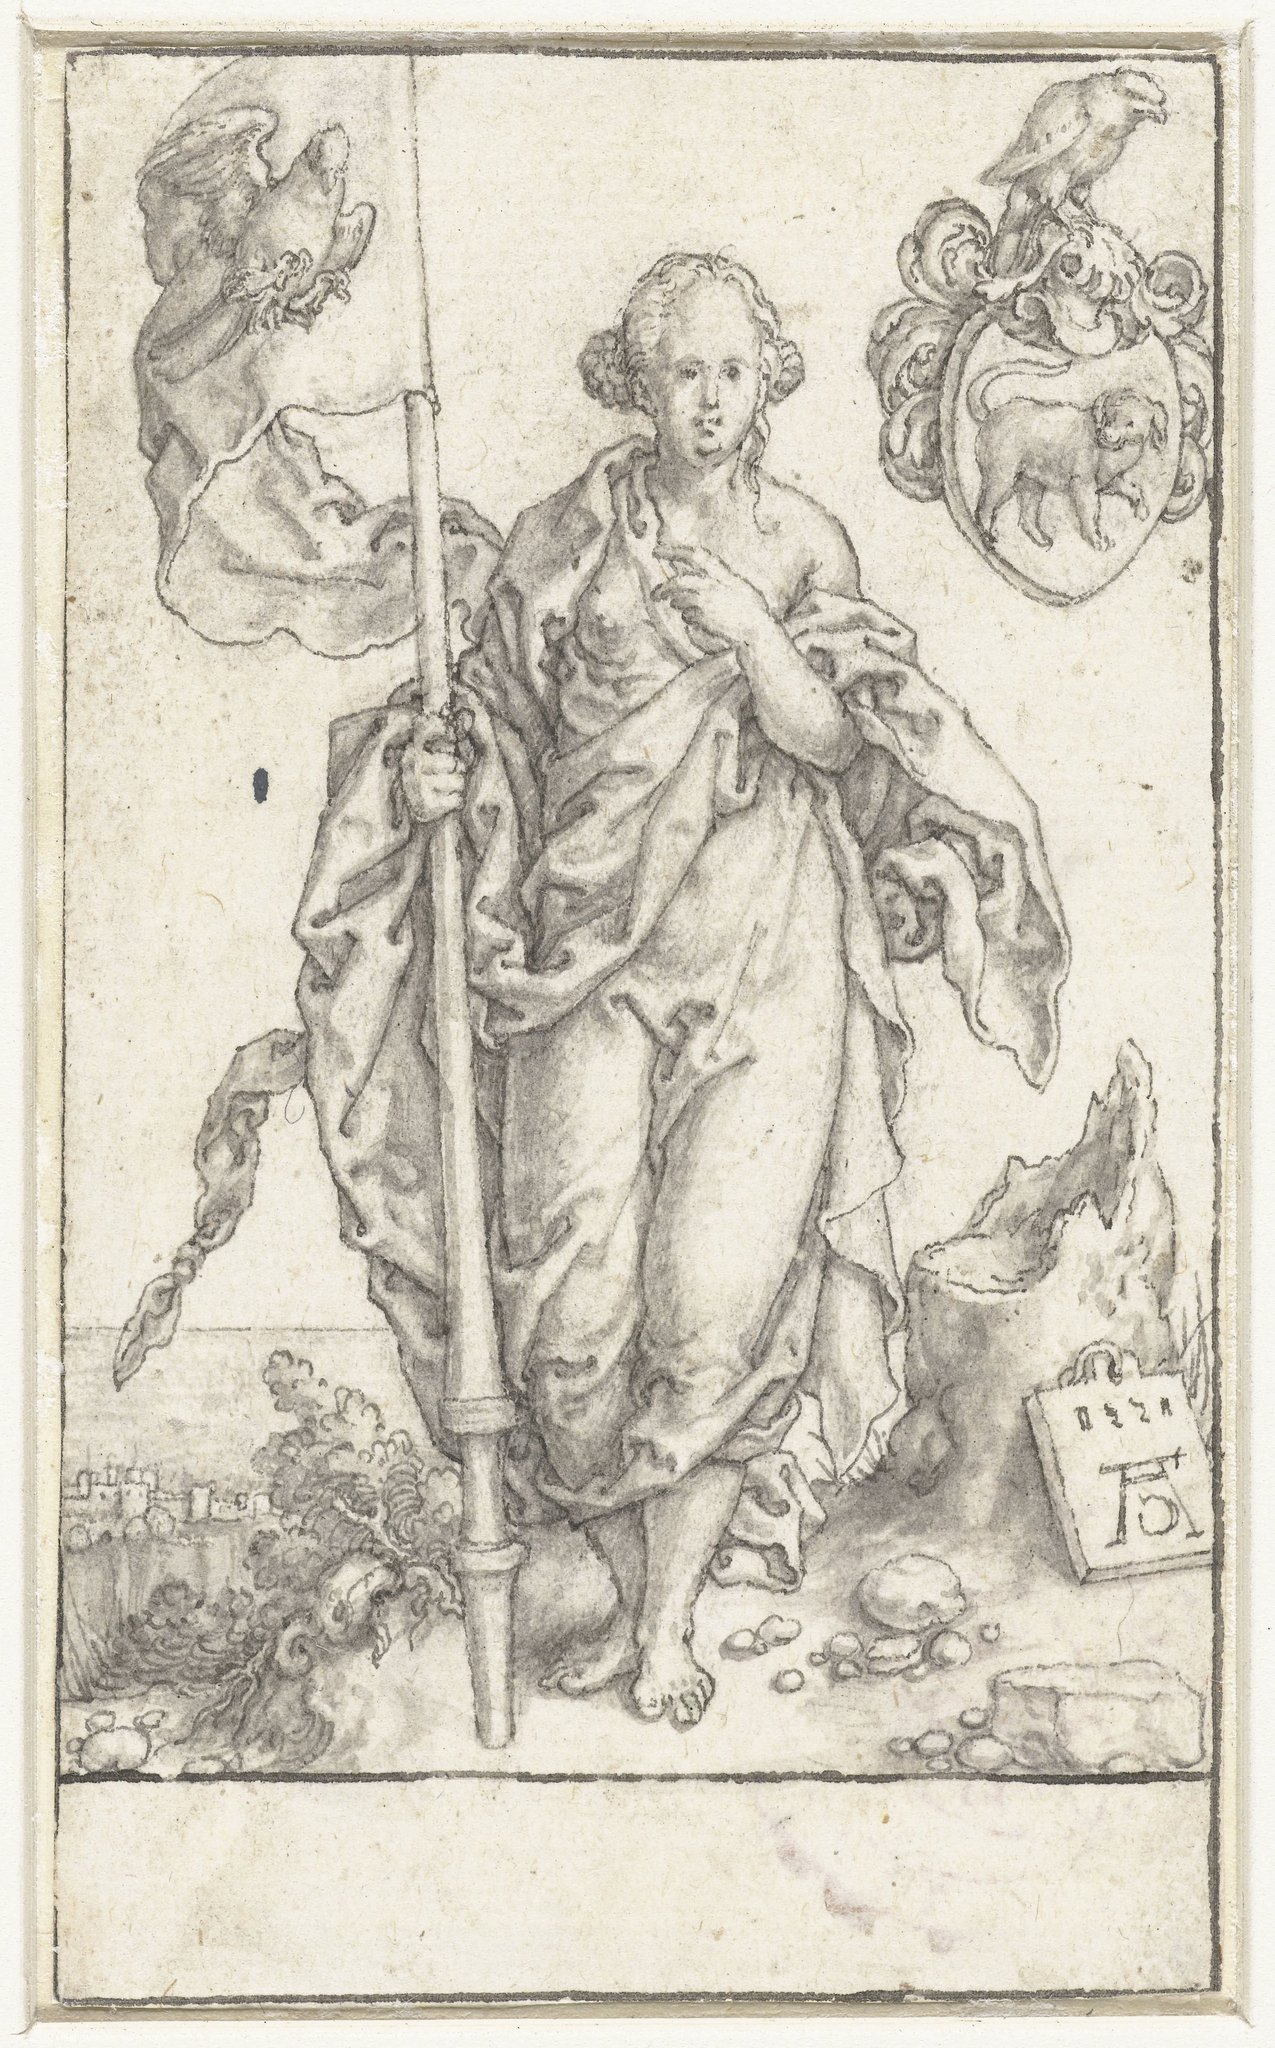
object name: design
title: Geduld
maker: heinrich aldegrever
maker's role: draughtsman, print maker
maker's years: 1502-1561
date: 1551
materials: ink, paper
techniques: brush, pen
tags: patience; 'patienza' (ripa) (+ abstract concept represented by female figure)